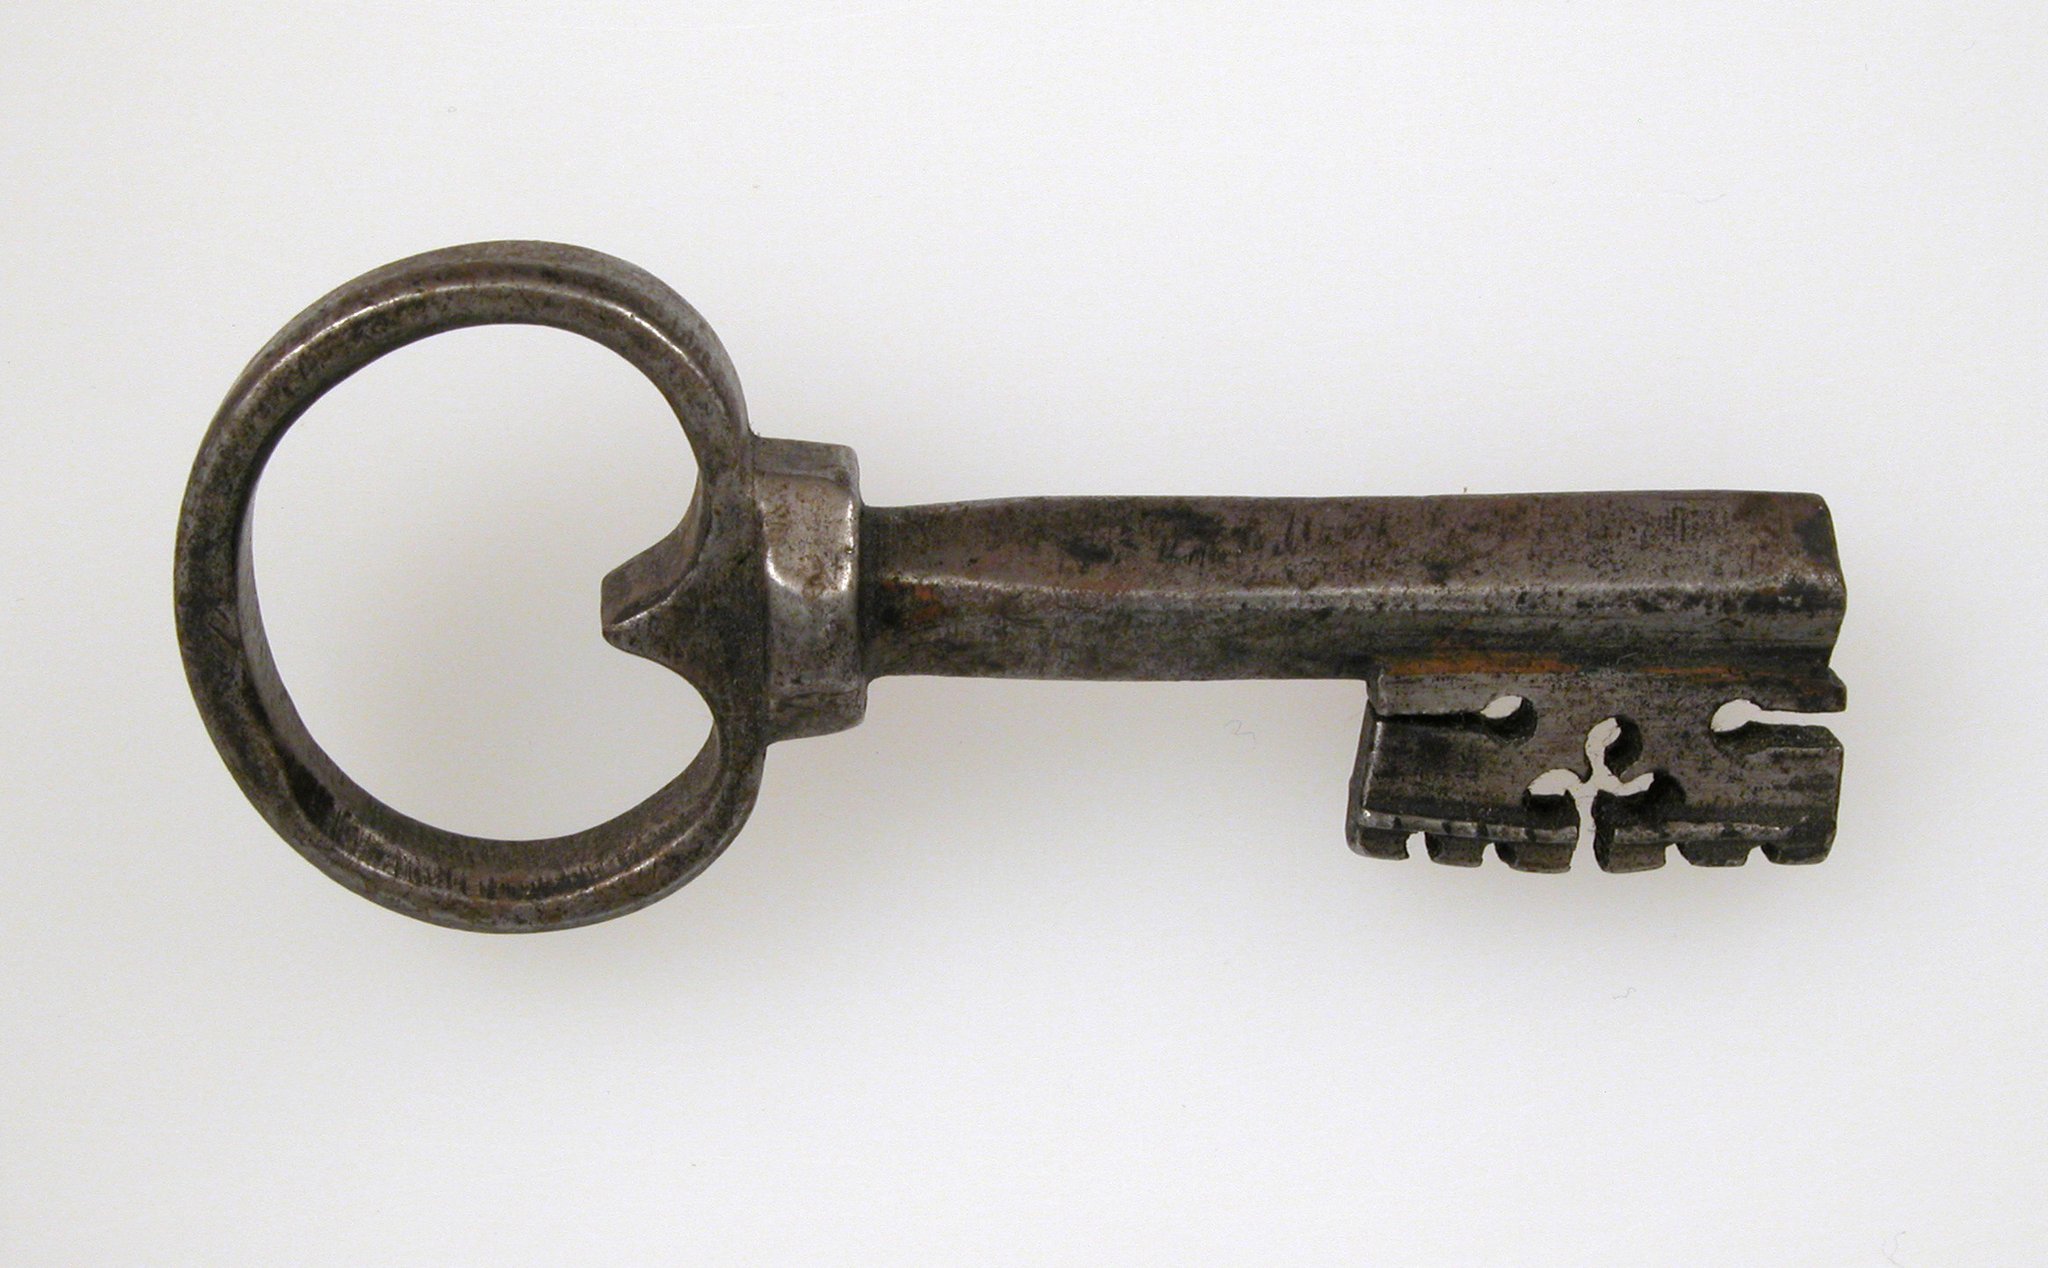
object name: key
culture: german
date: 1401-1500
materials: iron